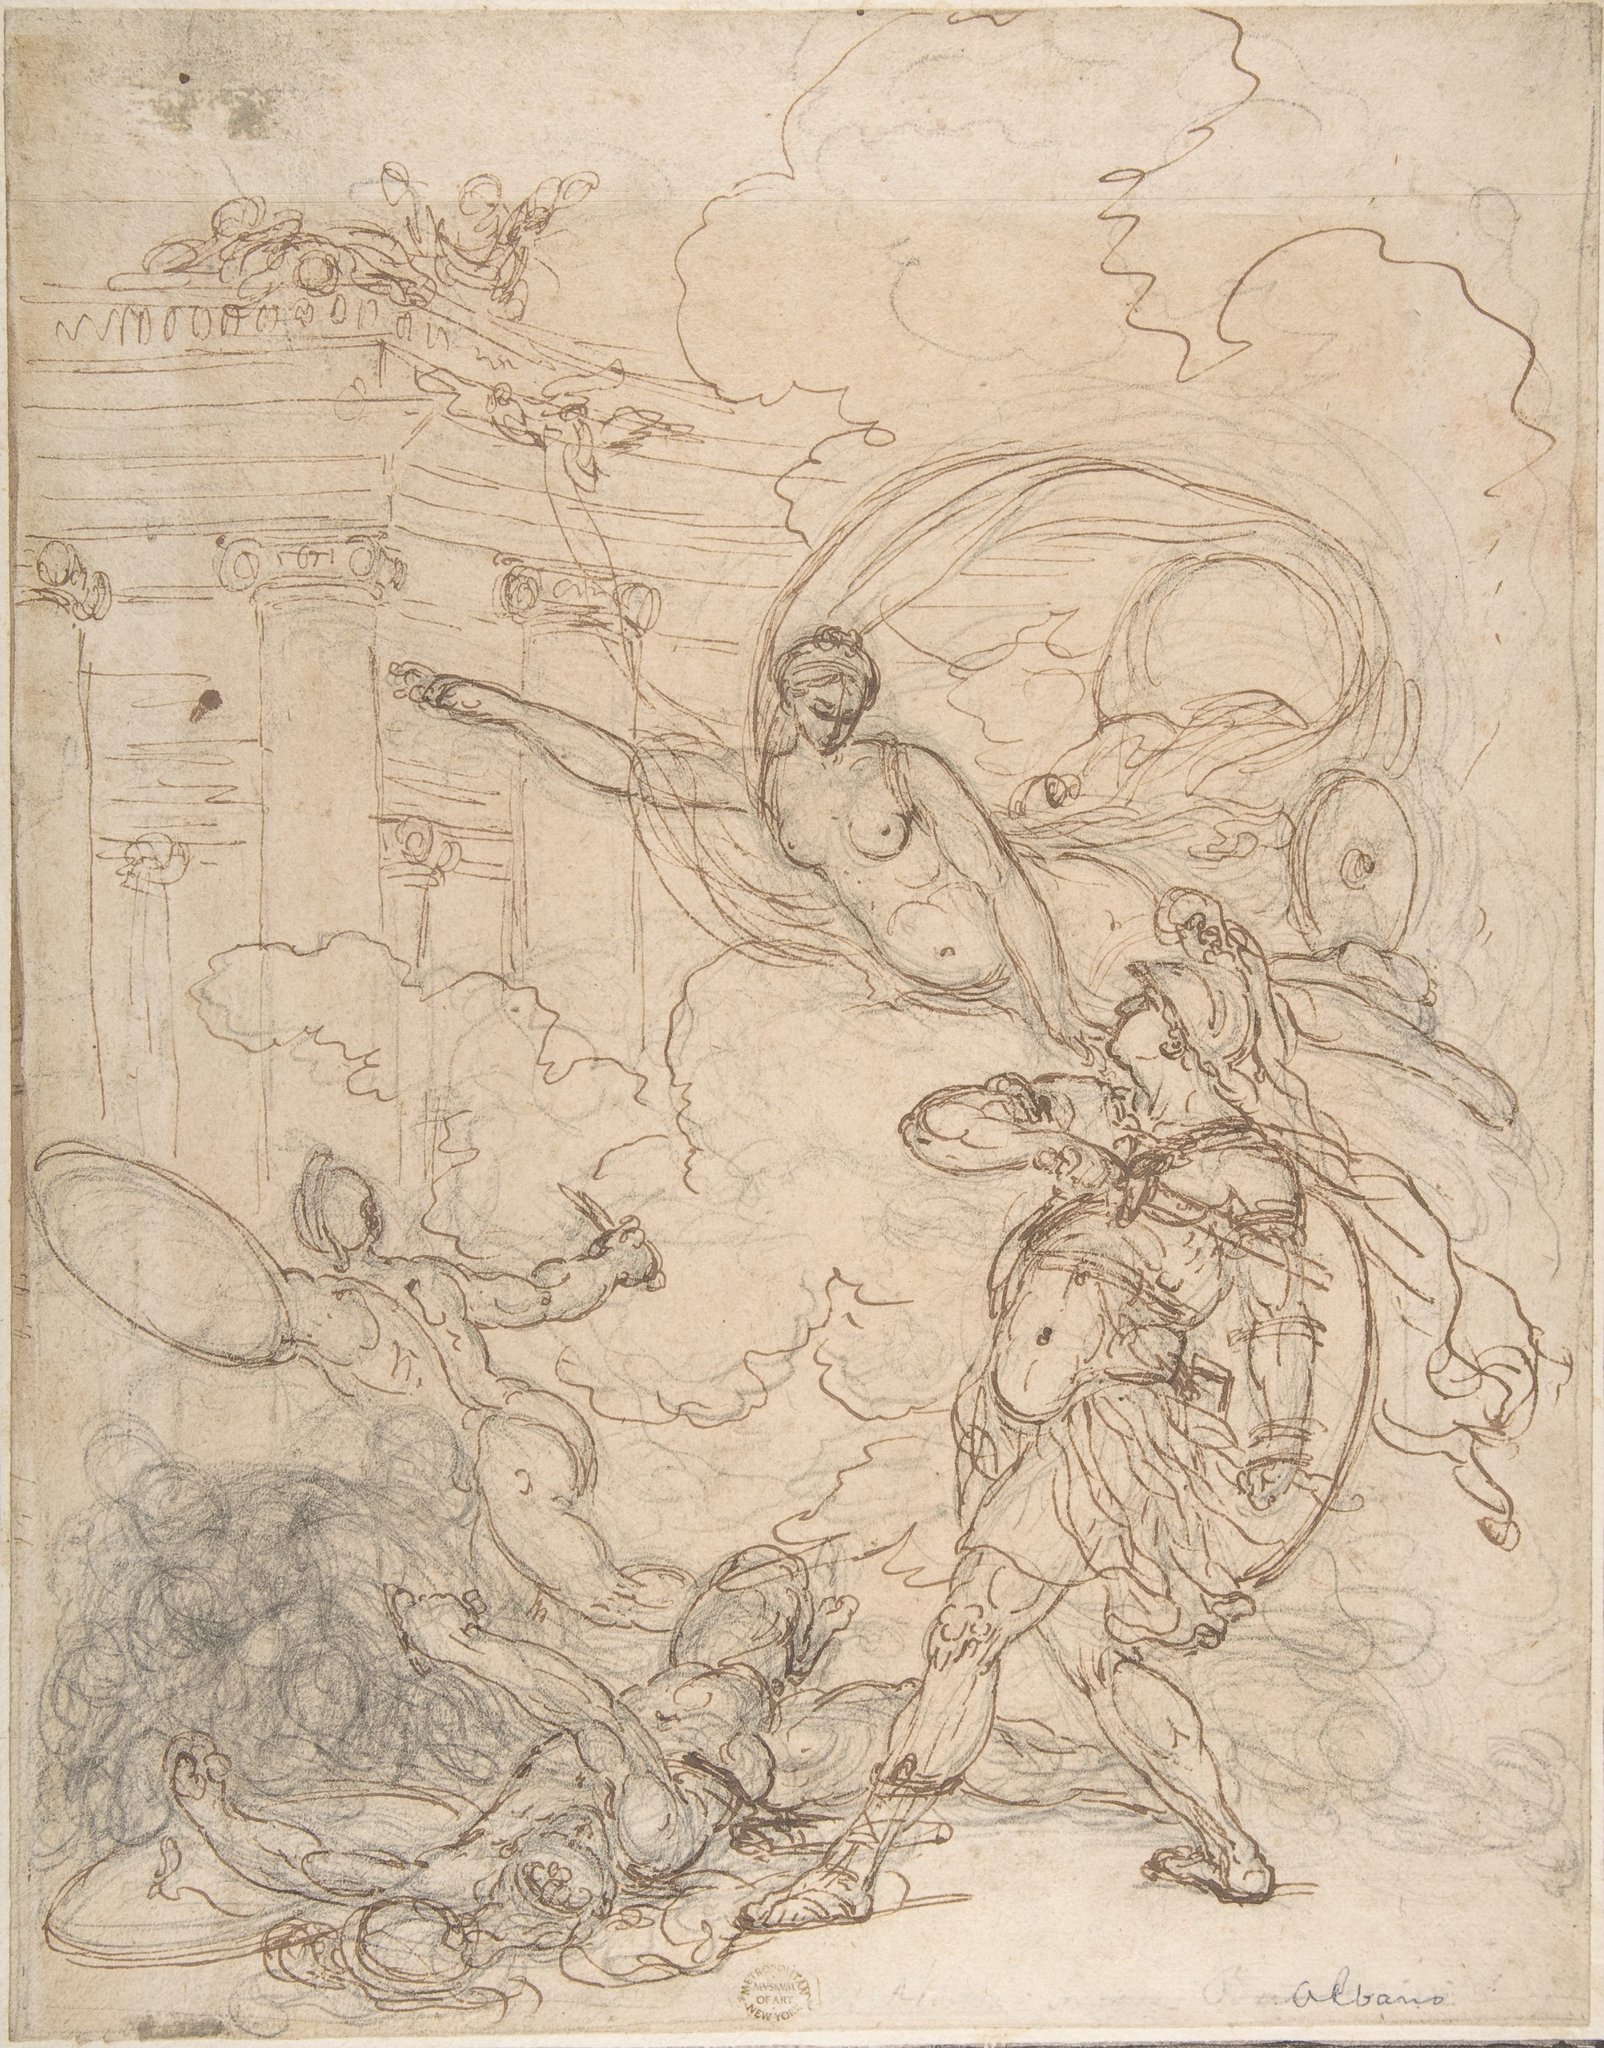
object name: drawing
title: Goddess Inciting a Warrior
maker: francesco albani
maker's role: artist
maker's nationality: italian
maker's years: 1578-1660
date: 1578-1660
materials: chalk, ink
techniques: pen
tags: soldiers,men,female nudes